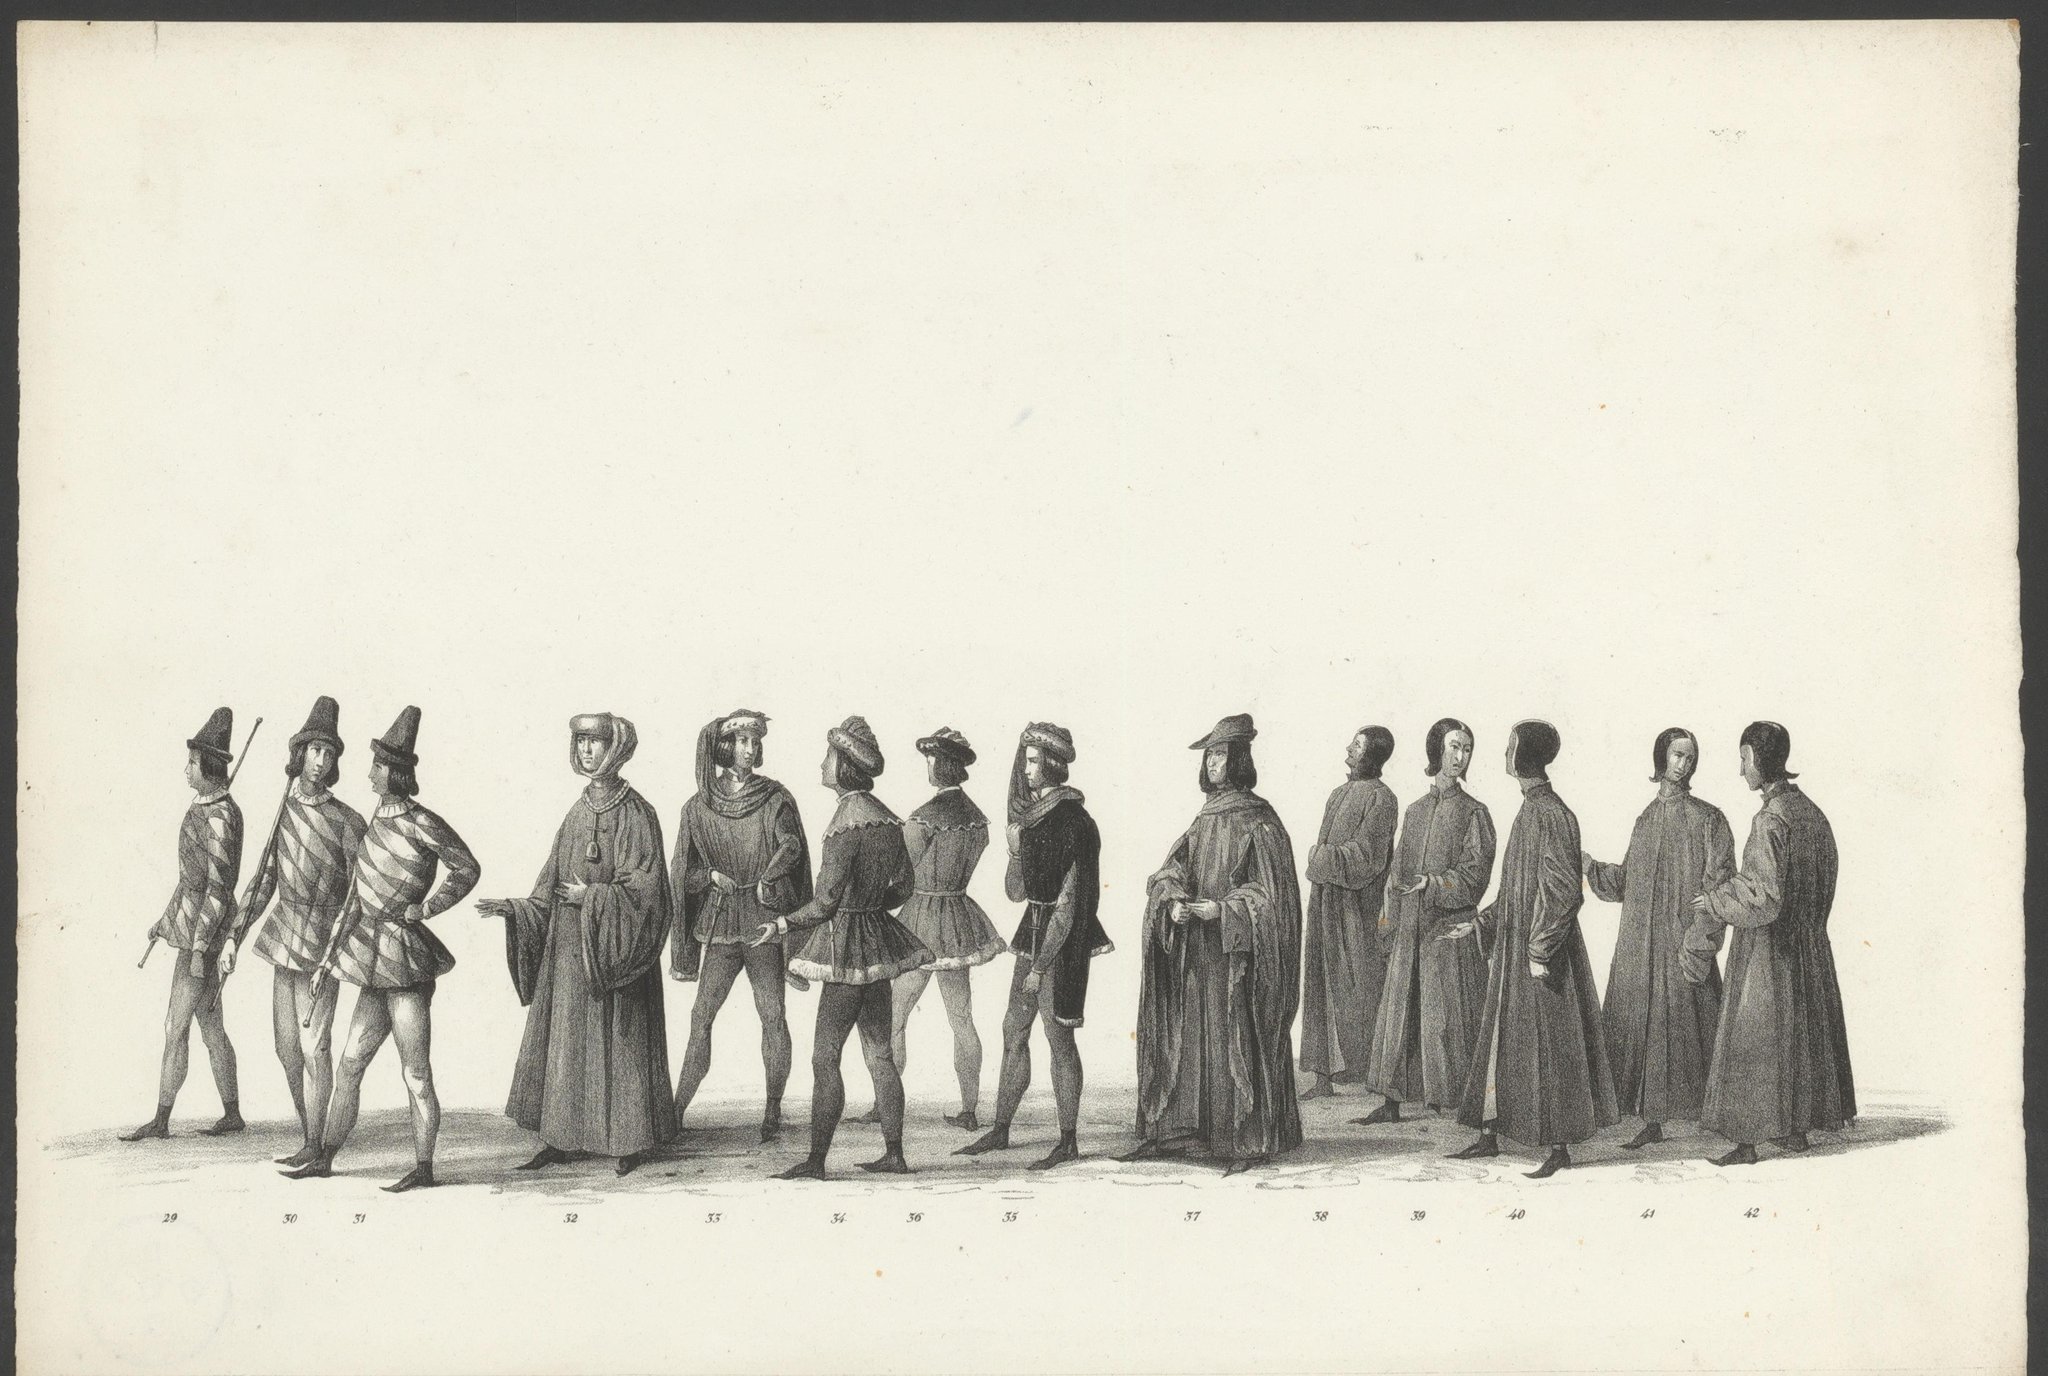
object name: print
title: De intogt van Hertog Jan van Beijeren binnen Leyden. Op den 18den Augustus 1420 in Maskerade voorgesteld door H.H. Studenten der Leydsche Hoogeschool, Op den 8sten Februarij 1840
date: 1840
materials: paper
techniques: lithograph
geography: leiden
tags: jan van beieren, students' pageant, triumphal entry and public reception, pageant, 'entrée solennelle', 'joyeuse entrée'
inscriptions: collector's mark: Lugt 1641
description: Boden, thesauriers, raden en klerken van de hertog. Historische gekostumeerde optocht van de studenten van de Hogeschool van Leiden op 8 februari 1840. De optocht verbeeldt de intocht van hertog Jan van Beieren te Leiden op 18 augustus 1420. Onderaan genummerd: 29 t/m 42. Onderwerpsrubrieken binnen de Atlas Zeden en Gewoonten: Onderwijs en Wetenschappen, Studentenleven.